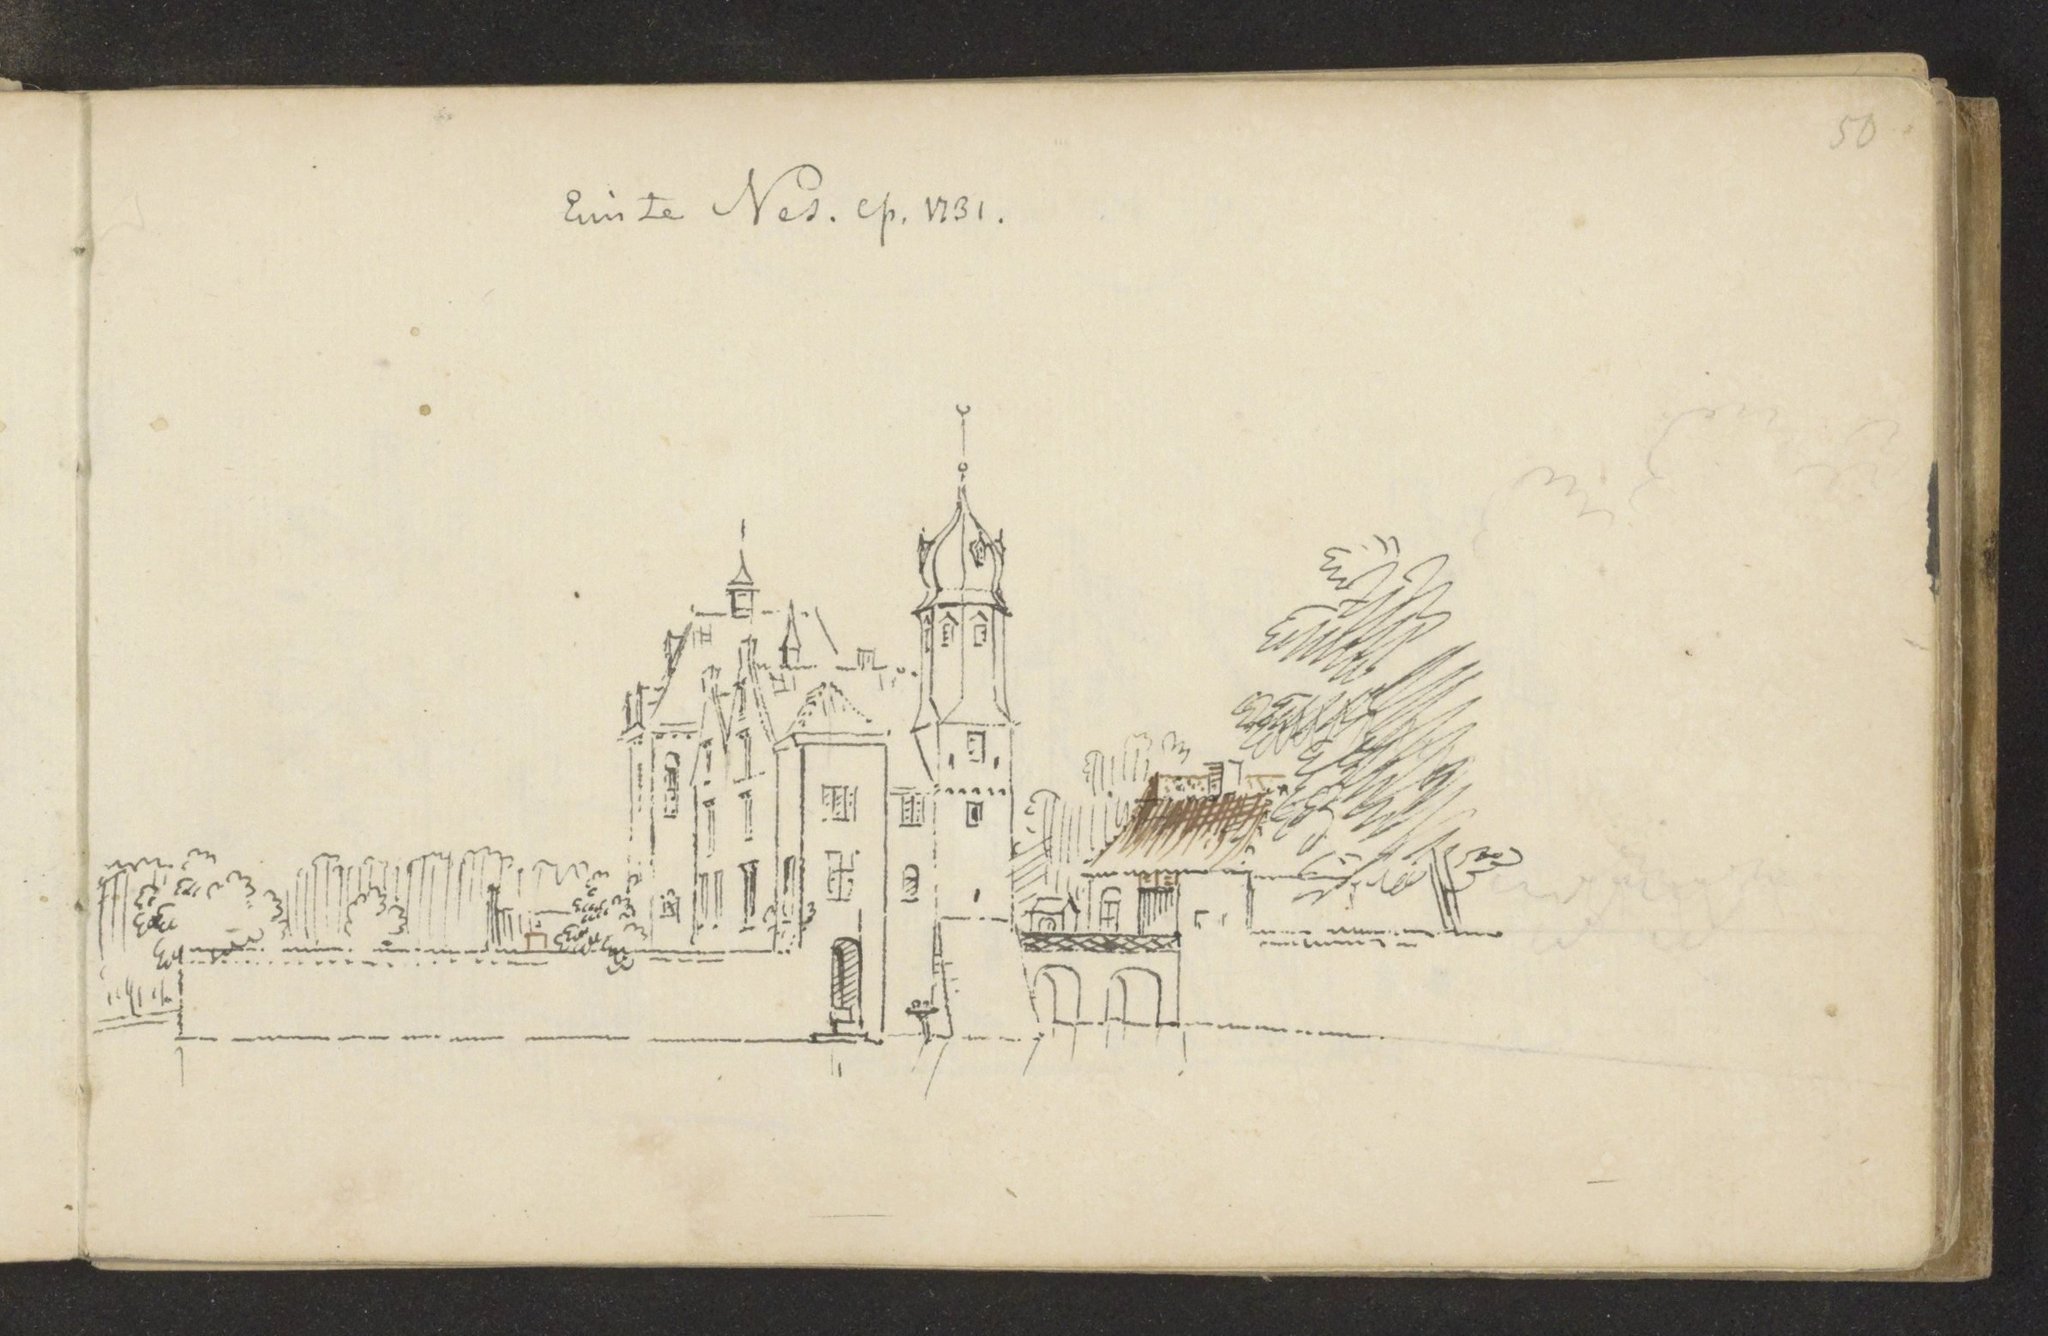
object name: sketchbook leaf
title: Huis te Nesse of De Nes te Linschoten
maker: abraham de haen (ii)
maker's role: draughtsman, print maker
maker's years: 1707-1748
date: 1731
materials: ink, paper, pencil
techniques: pen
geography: linschoten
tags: castle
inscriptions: date and inscription: ‘huis te Nes.cp.1731.’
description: Blad 50 recto uit een schetsboek met 78 bladen.